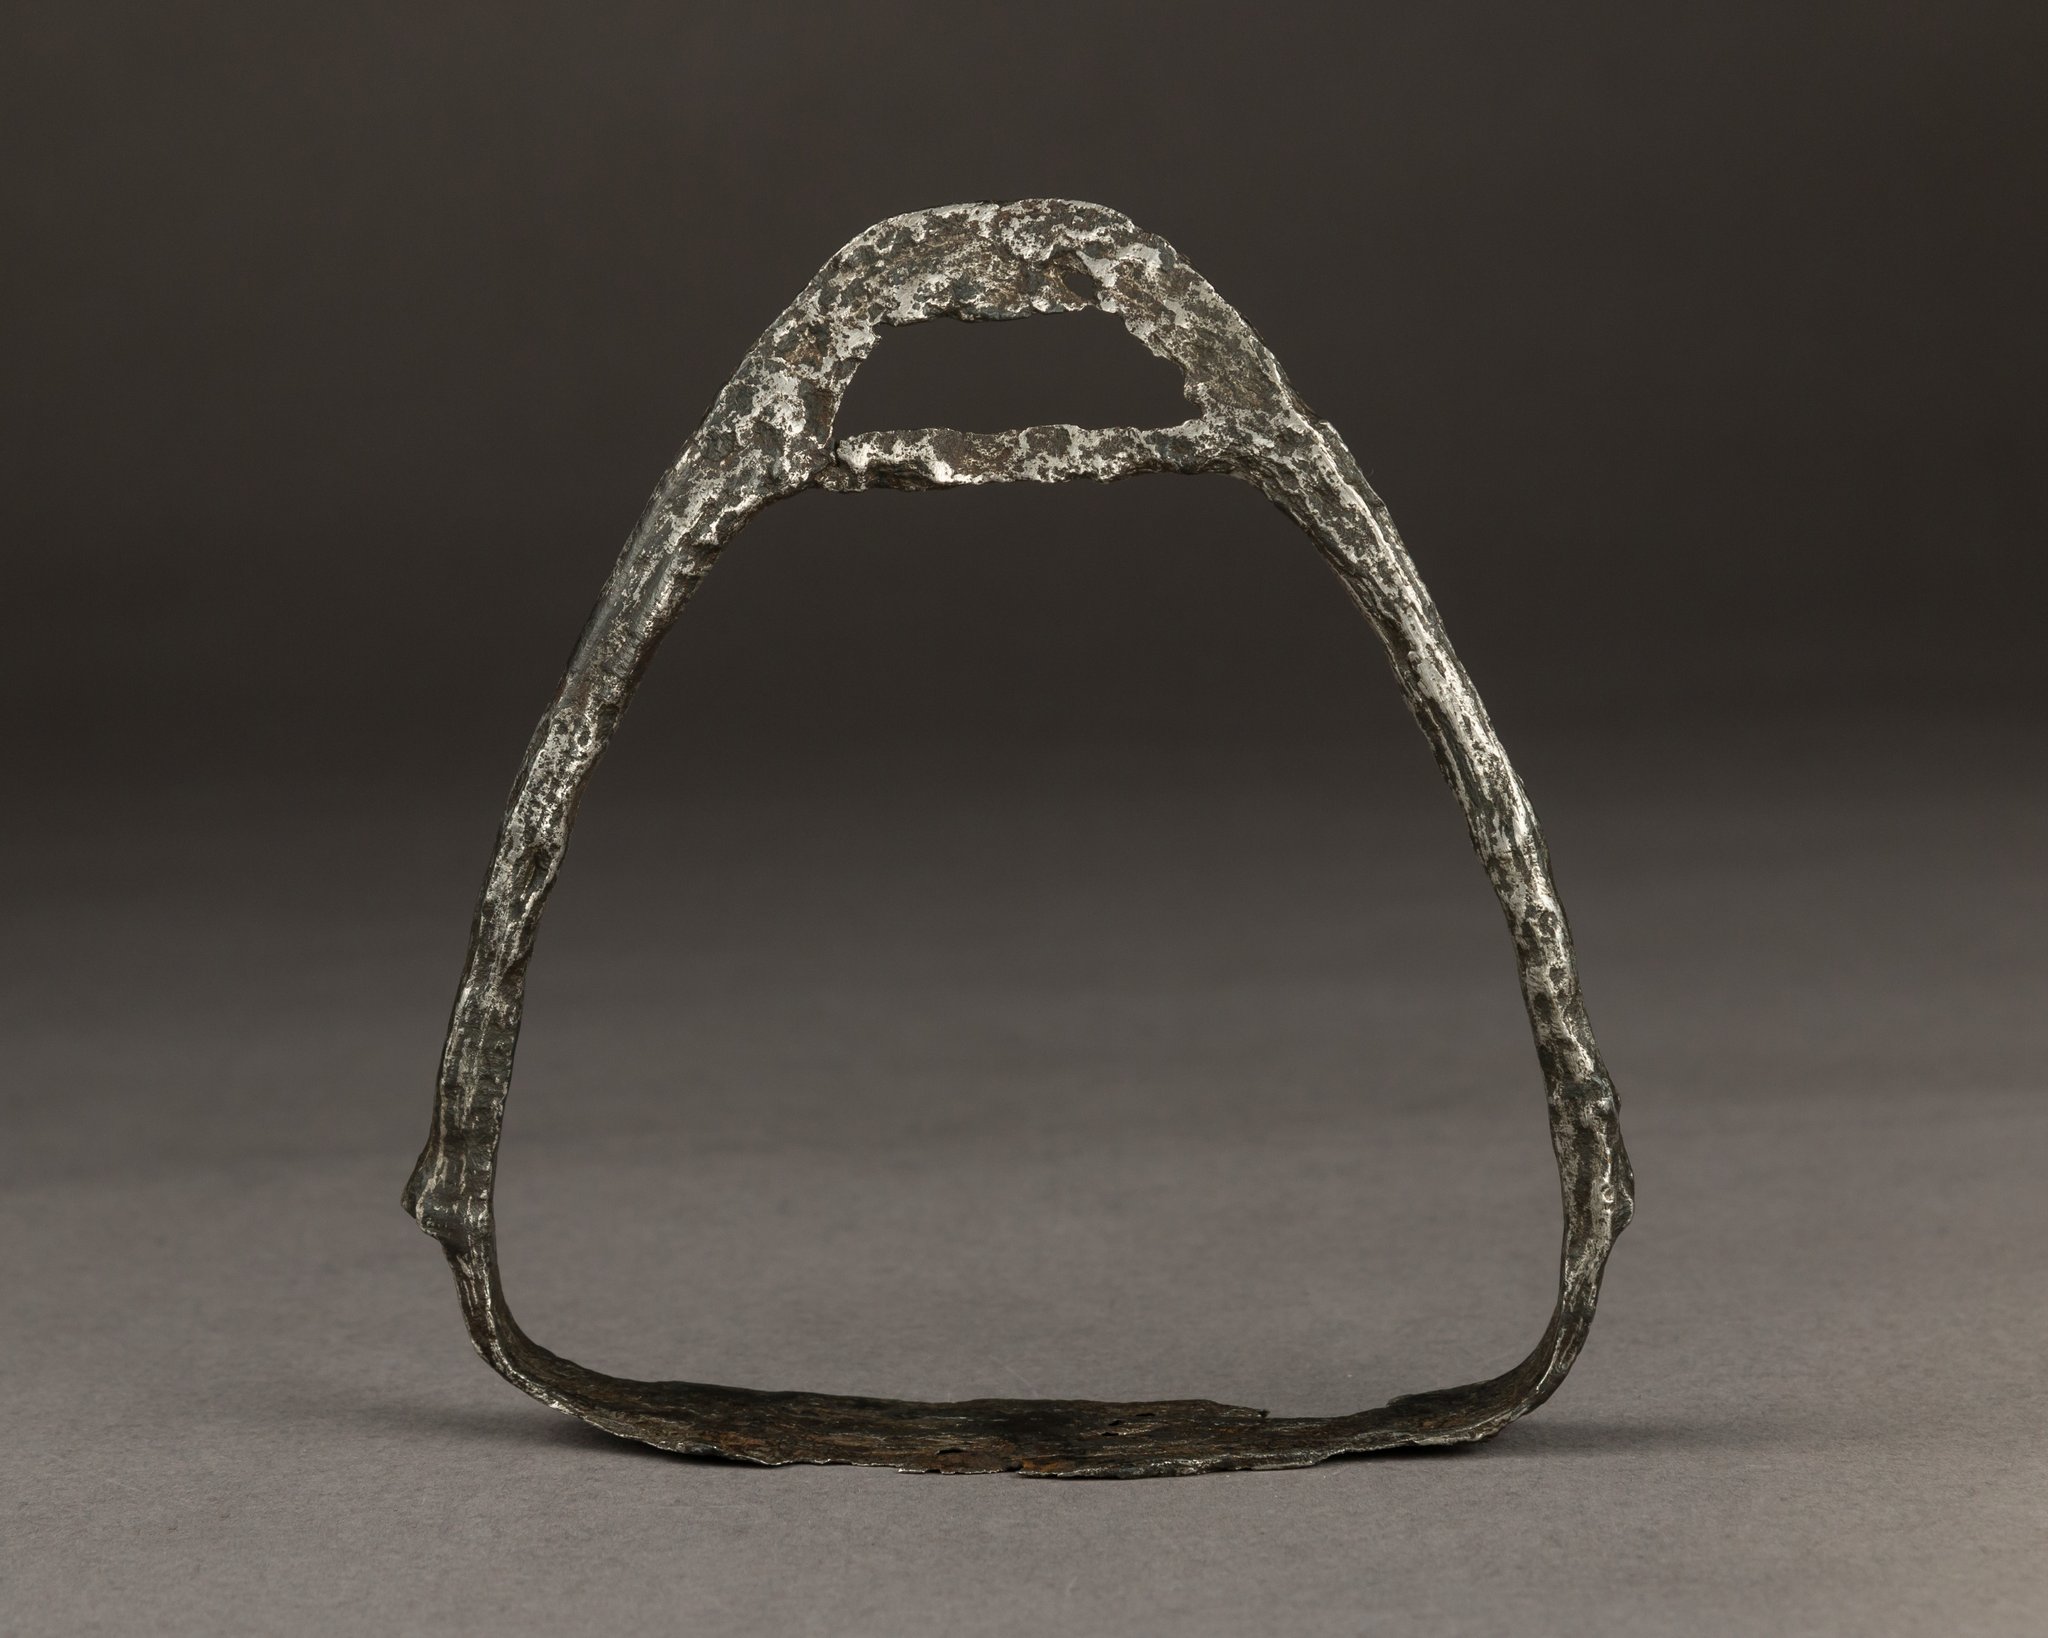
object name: stirrup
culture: west slavic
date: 901-1100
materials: iron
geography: poland